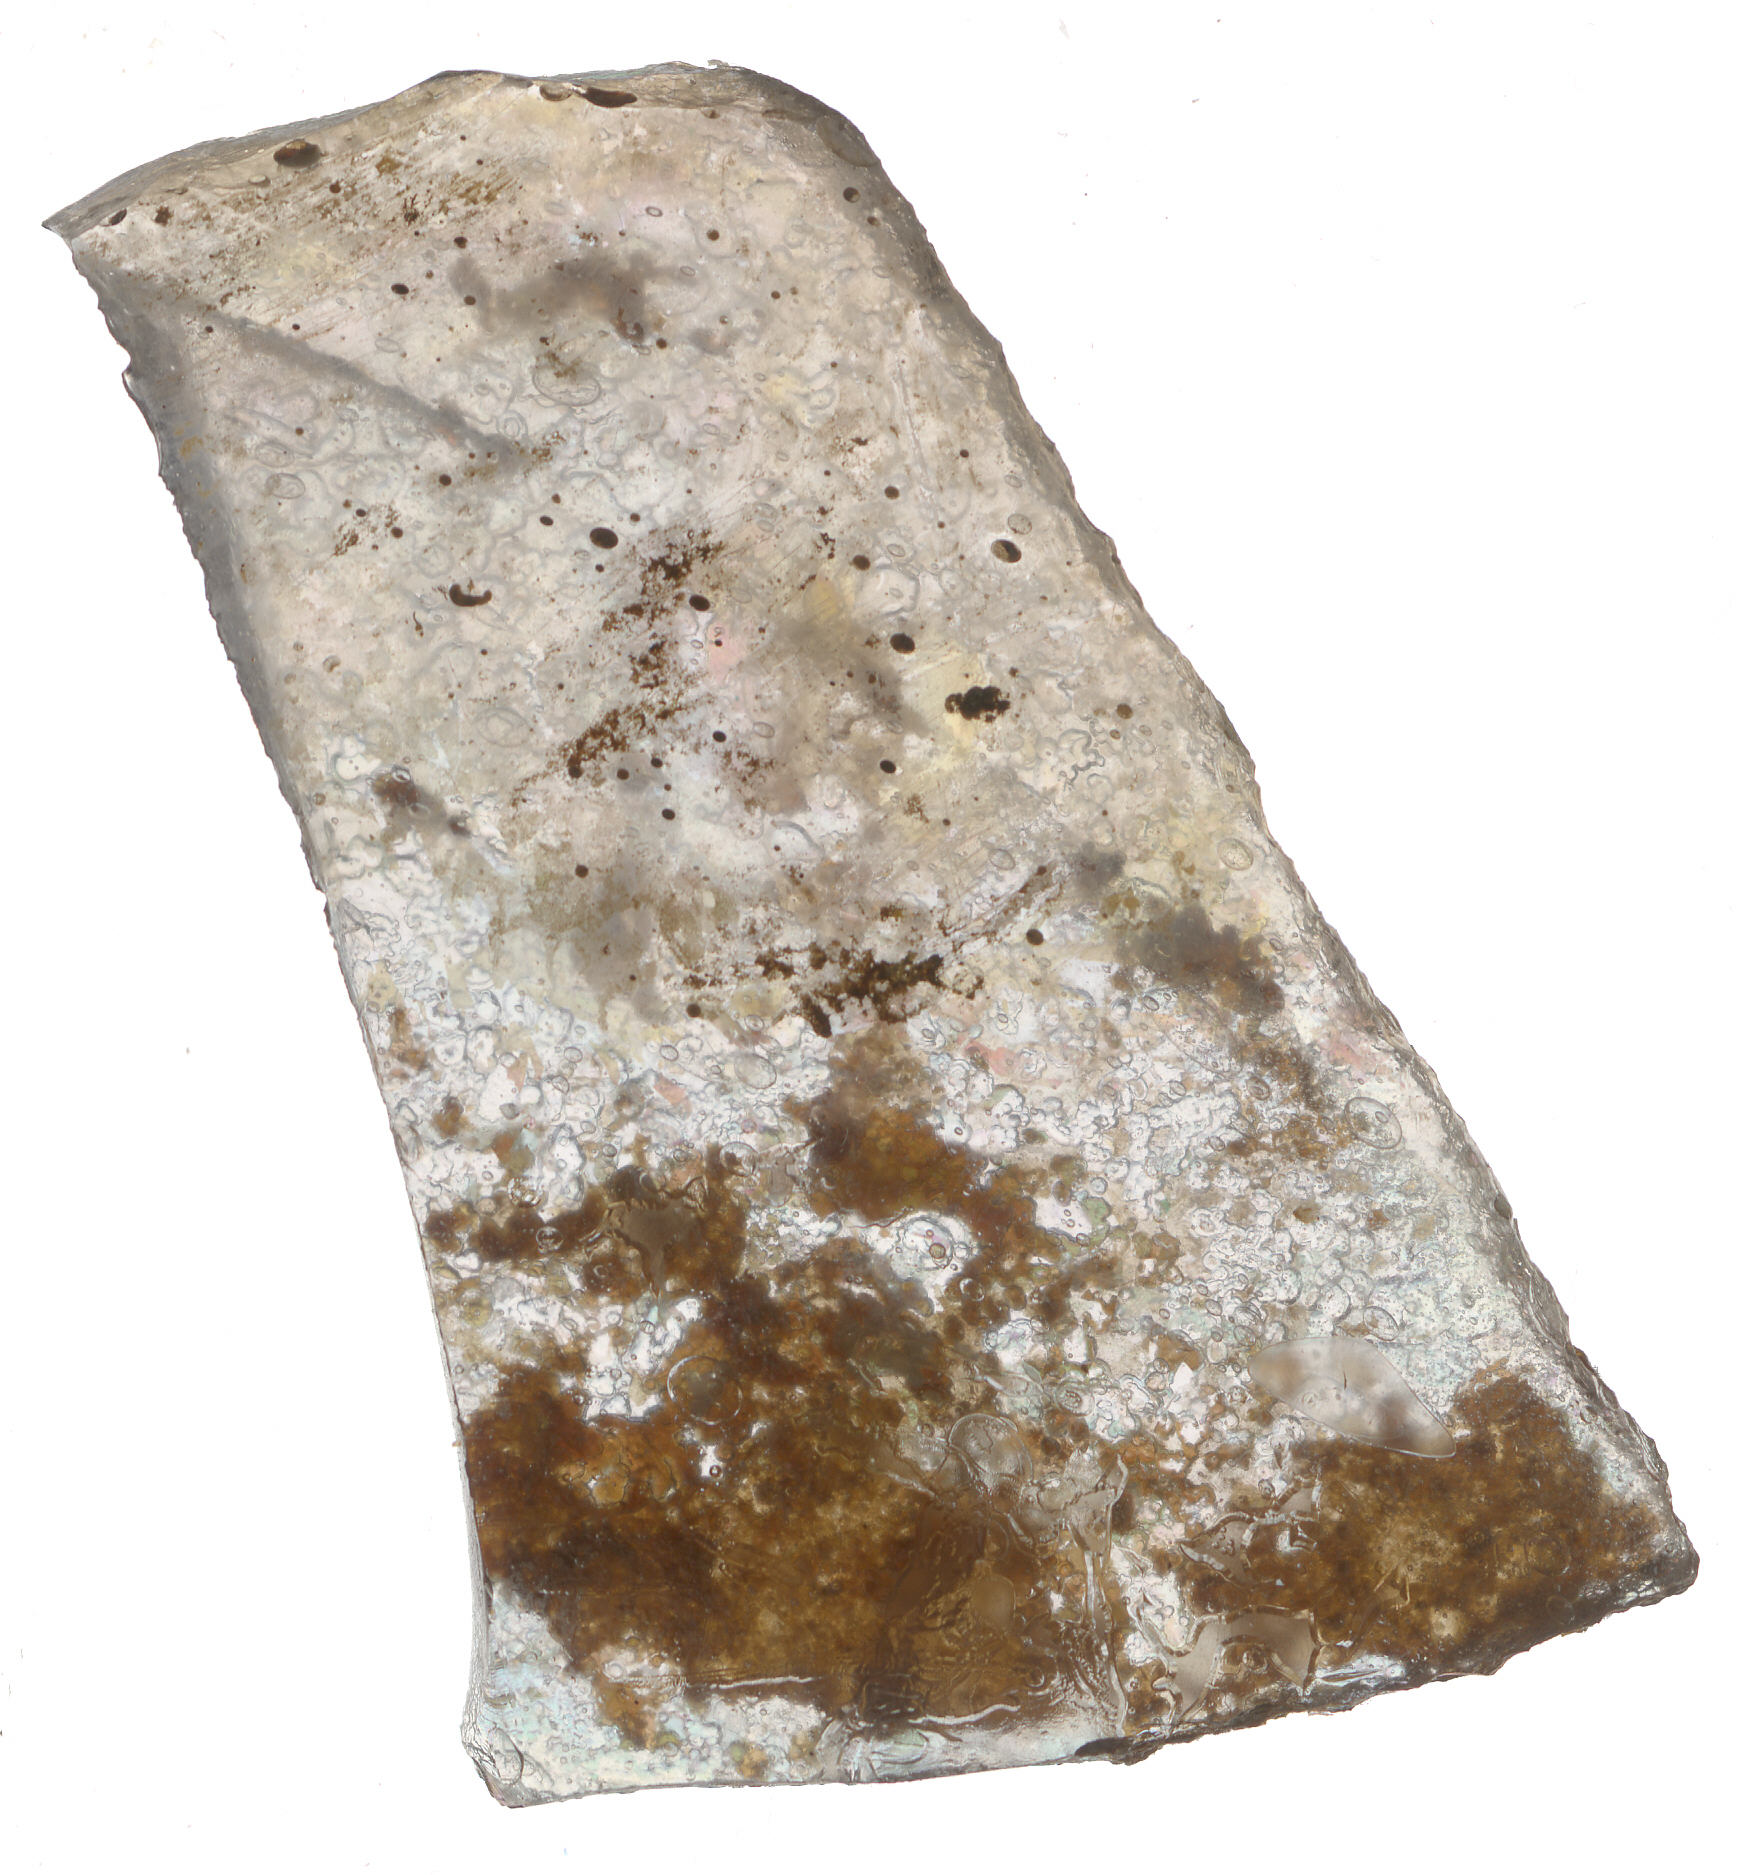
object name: fragment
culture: crusader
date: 1201-1300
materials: glass